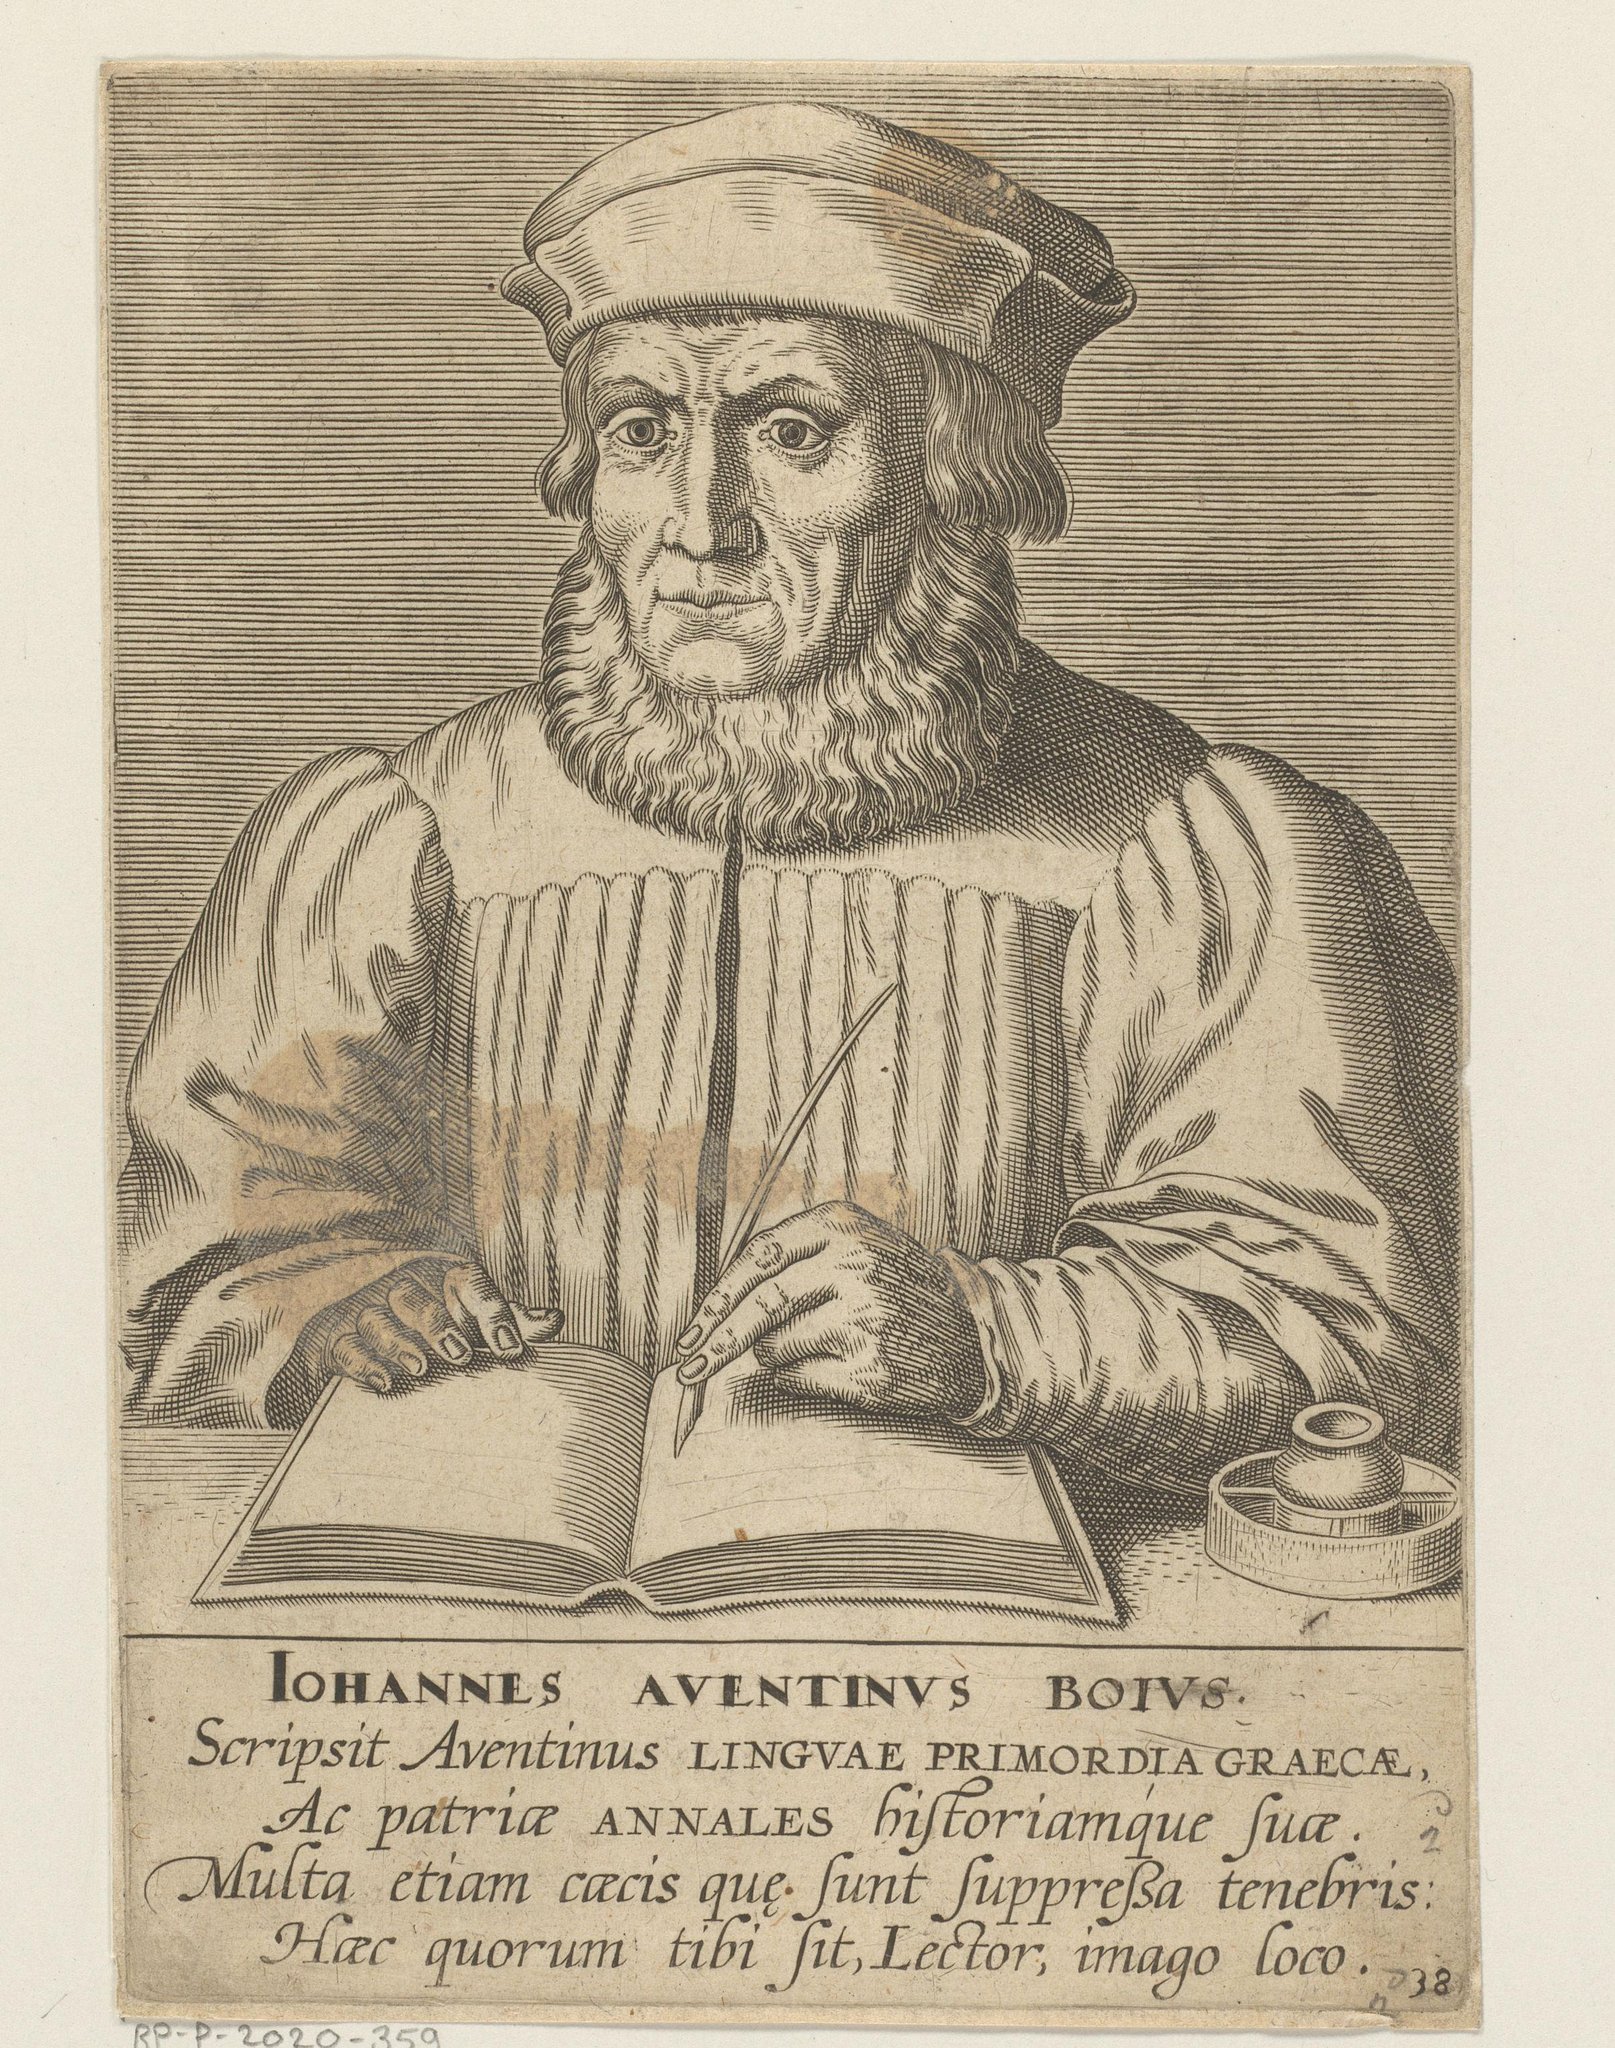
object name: print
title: Imagines L. doctorum virorum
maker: philips galle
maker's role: print maker, publisher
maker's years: 1537-1612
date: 1587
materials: paper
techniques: engraving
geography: antwerp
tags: theologian, historical persons, book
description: Prent uit: Imagines L. doctorum virorum, qui bene de studiis literarum meruere. Antwerpen: Philips Galle, 1587. Prent ook gebruikt in latere edities van dit werk. Eerdere staat (zonder onderschrift) verschenen in: Virorum doctorum de disciplinis benemerentium effigies. Antwerpen: Philips Galle, 1567.